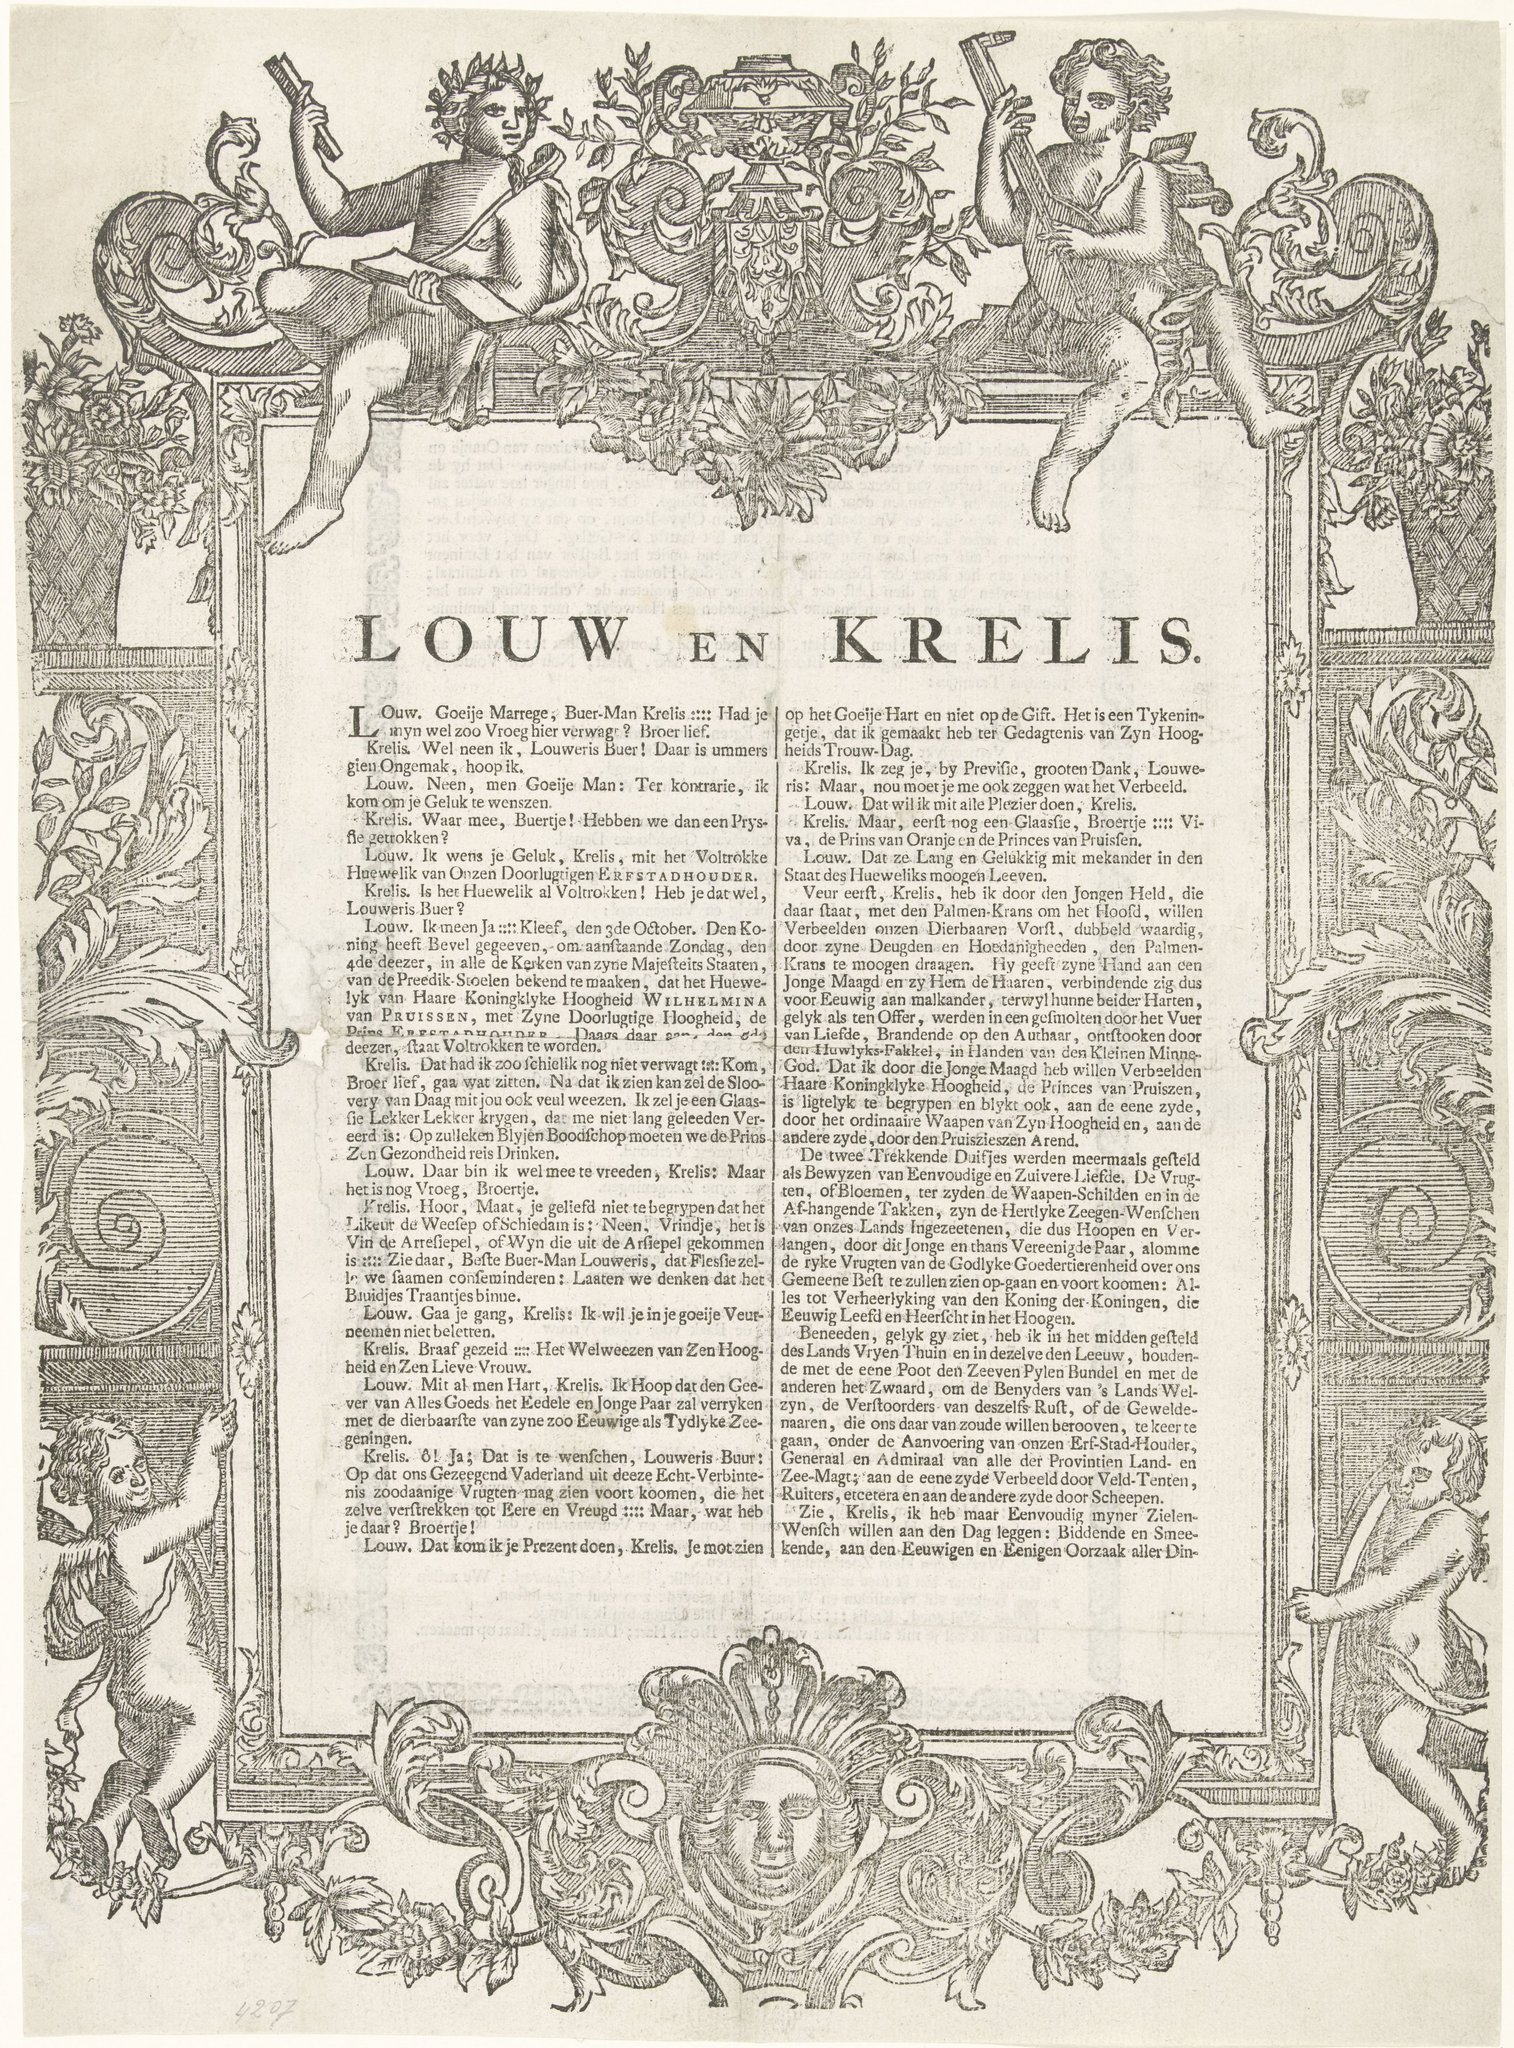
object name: print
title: Louw en Krelis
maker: Anonymous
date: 1767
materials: paper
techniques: letterpress printing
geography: northern netherlands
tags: william v (prince of orange), berlin, painter, draughtsman, wilhelmina of prussia (princess of orange)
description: Samenspraak van Louw en Krelis, ter gelegenheid van het huwelijk van stadhouder Willem V en prinses Wilhelmina van Pruisen op 4 oktober 1767. Tekst in boekdruk in twee kolommen binnen een ornamentele rand putti en bladranken. Vervolg van de tekst op de achterzijde.